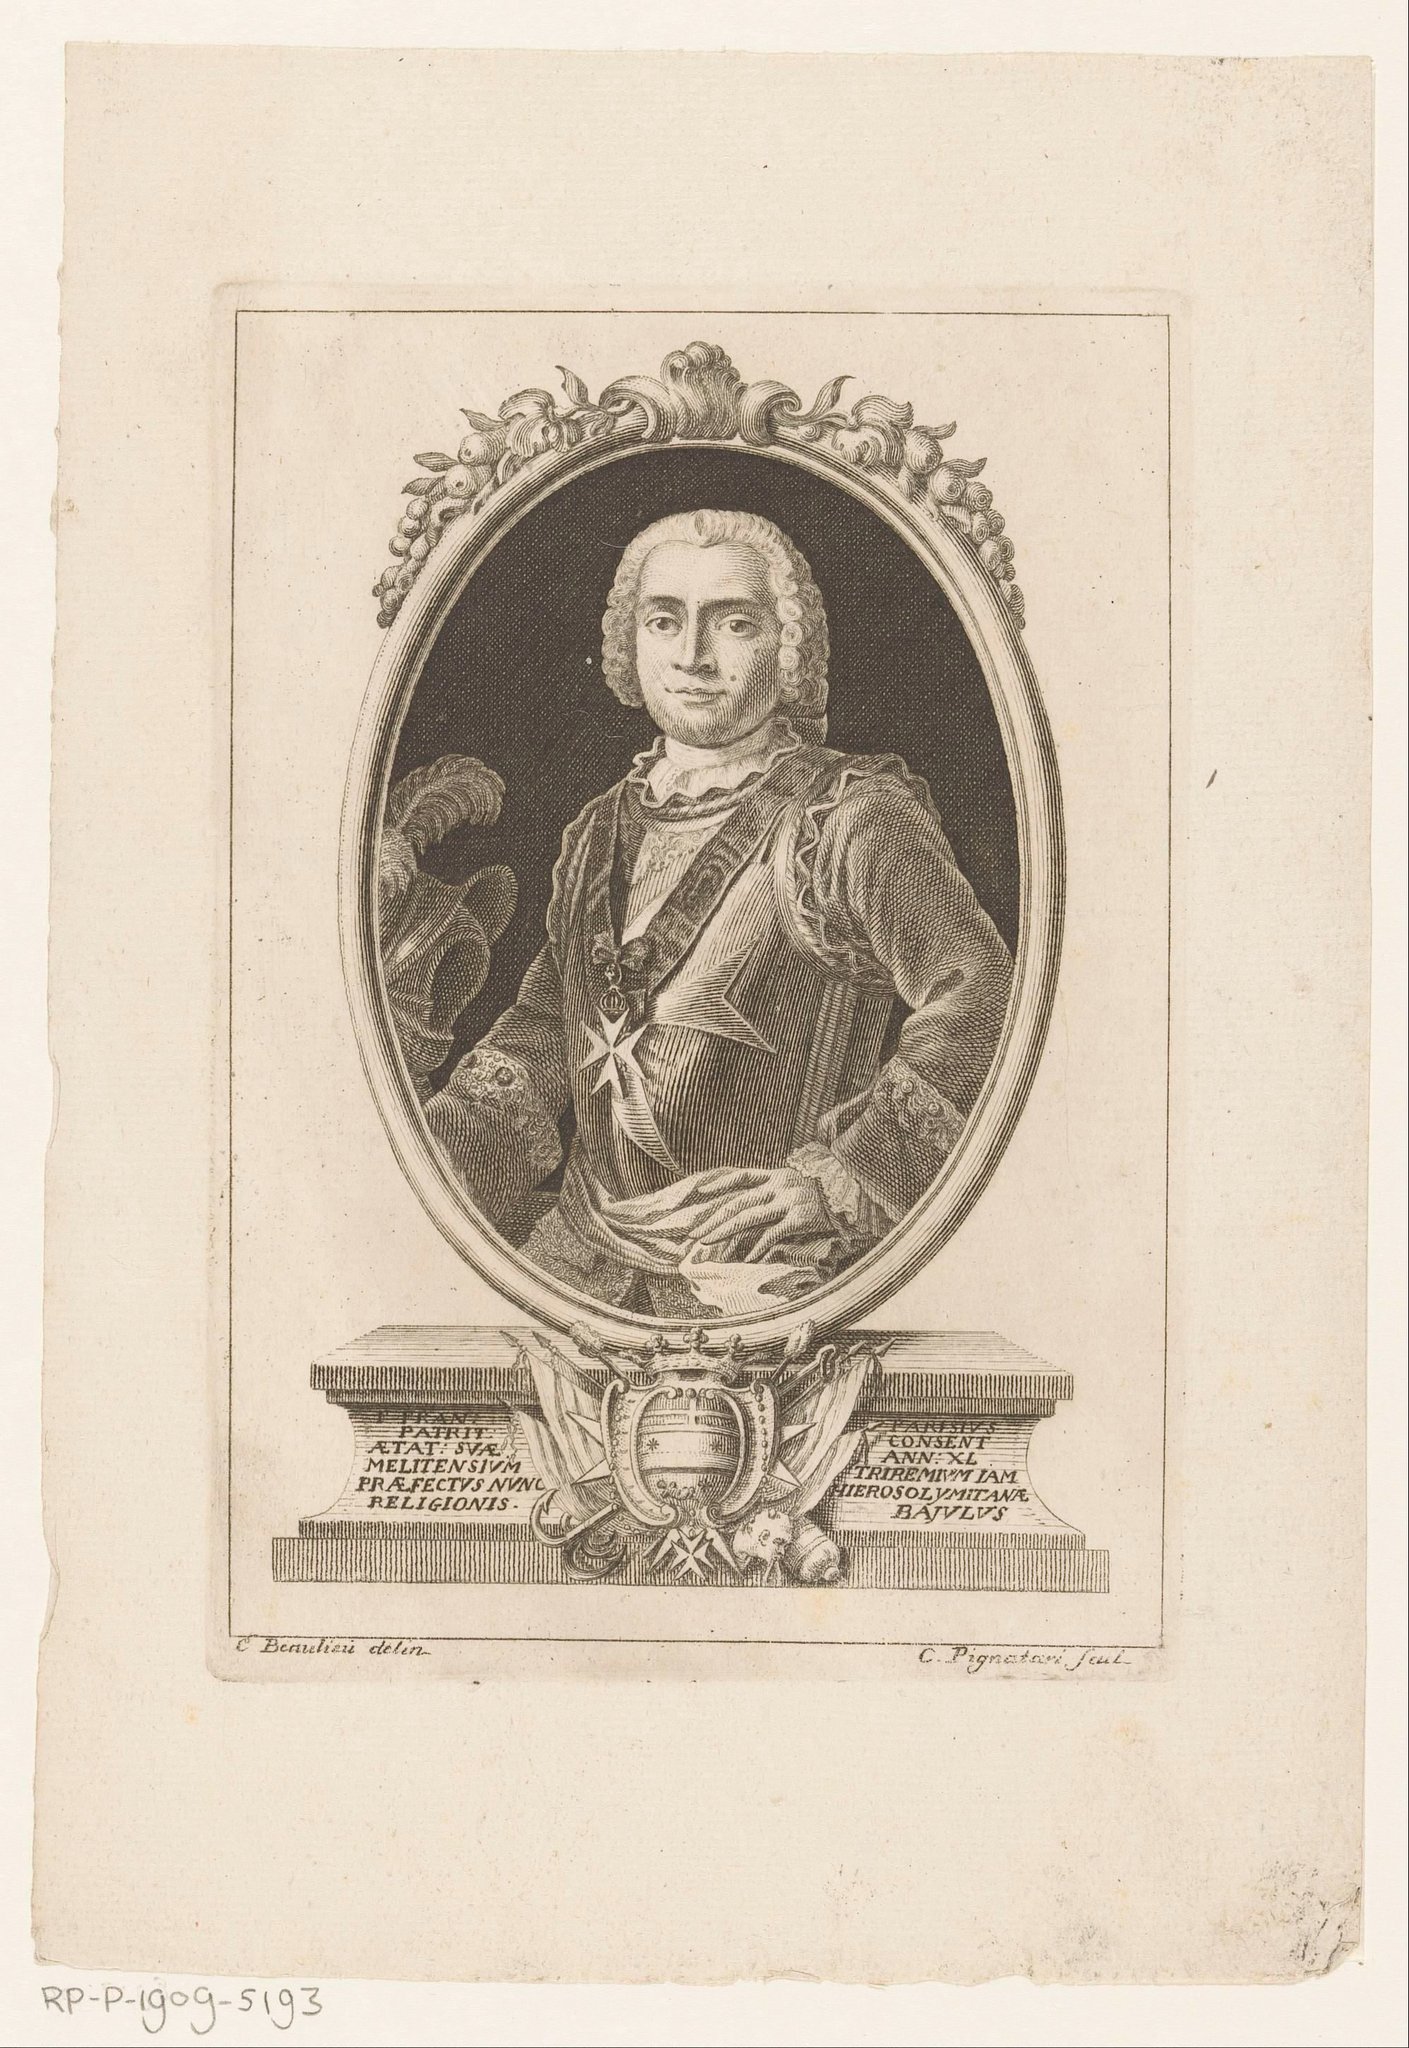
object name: print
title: Portret van Francesco Parisio met het kruis van de Maltezer Orde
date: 1700-1799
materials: paper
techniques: engraving, etching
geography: italy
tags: historical persons, military orders, e.g.: knights templars, knights of malta, teutonic knights ~ roman catholic church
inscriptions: collector's mark: Lugt 2228